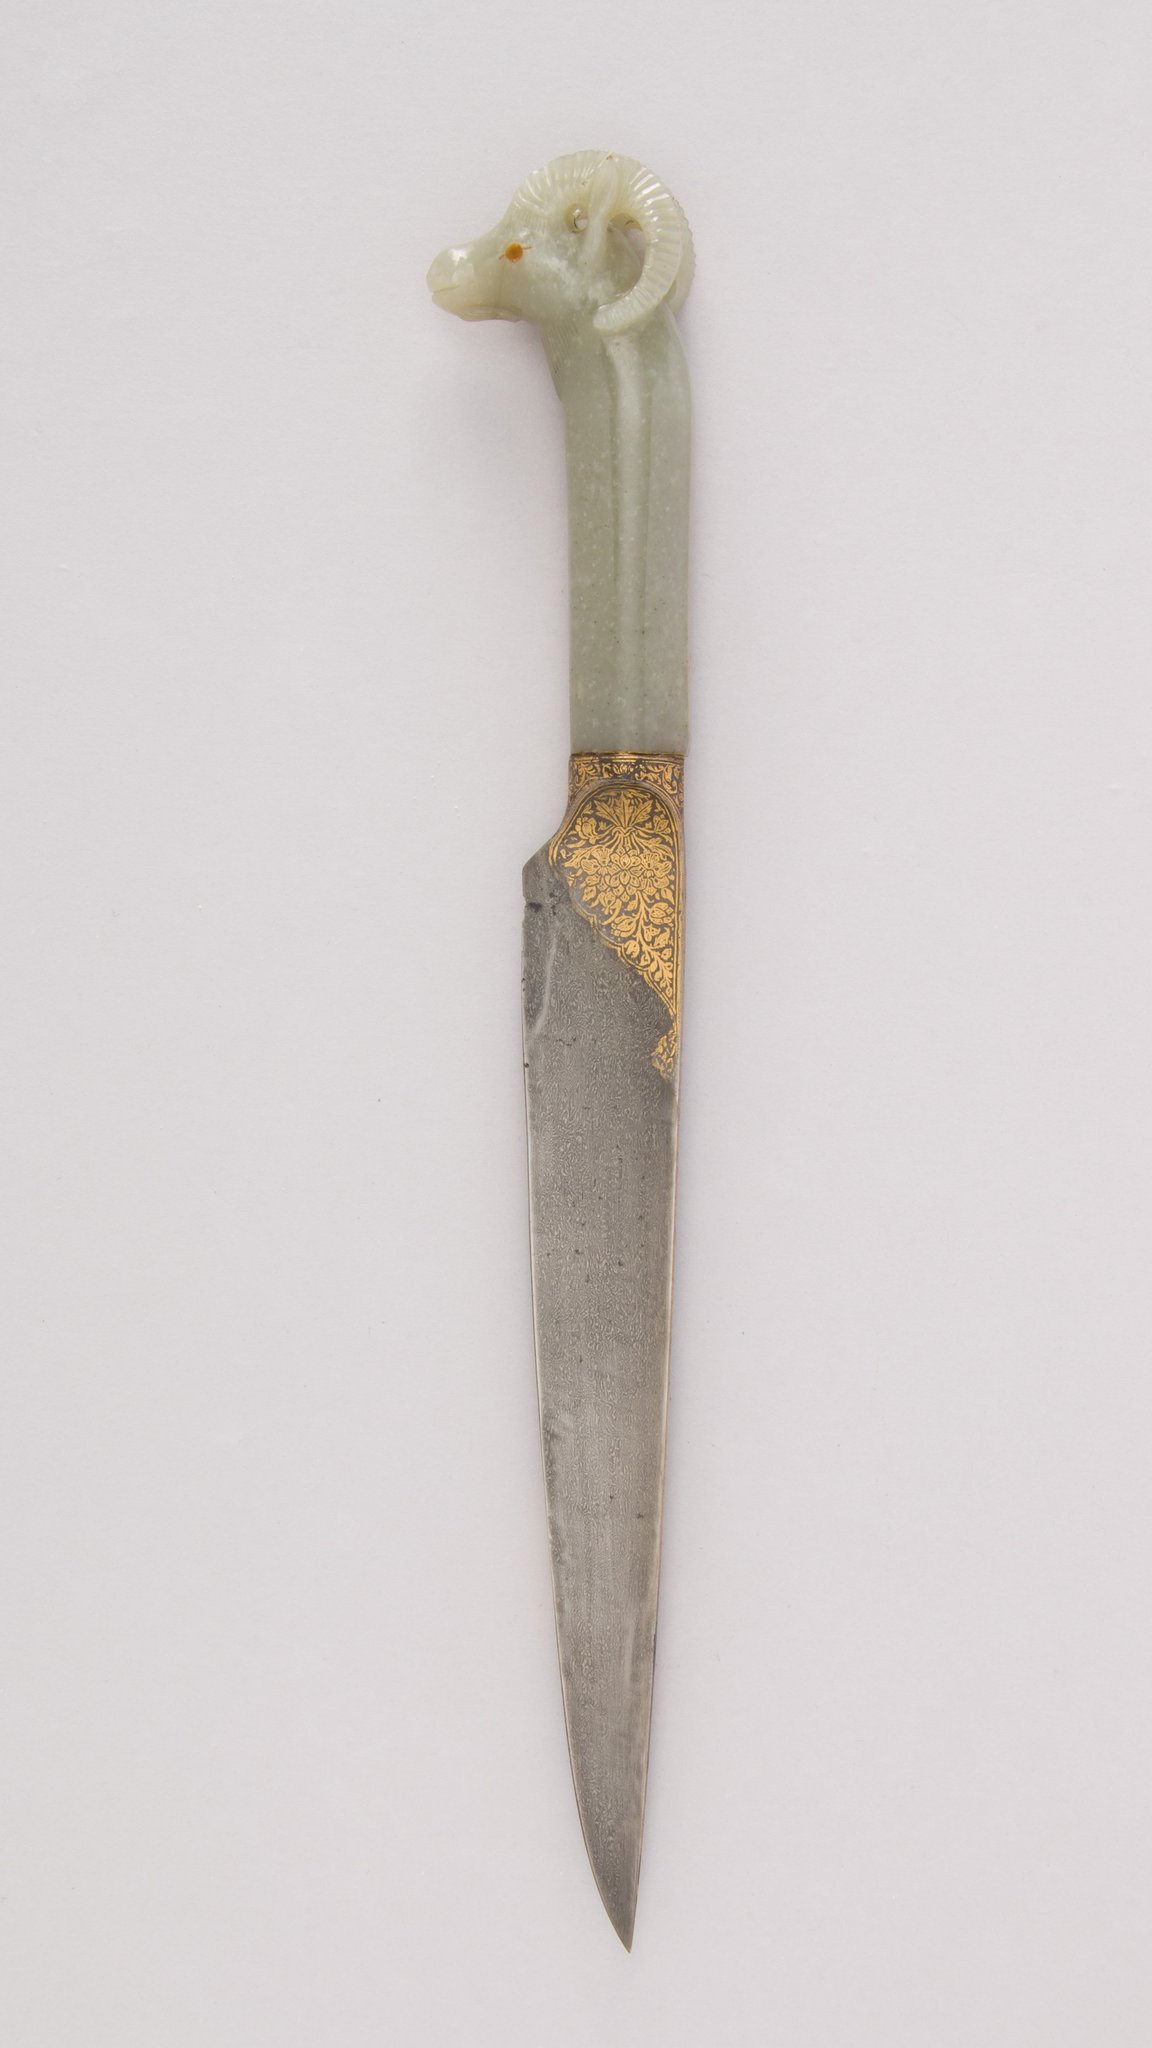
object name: dagger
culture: indian, mughal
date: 1701-1800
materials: gold, jade, gemstone, steel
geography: india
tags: rams